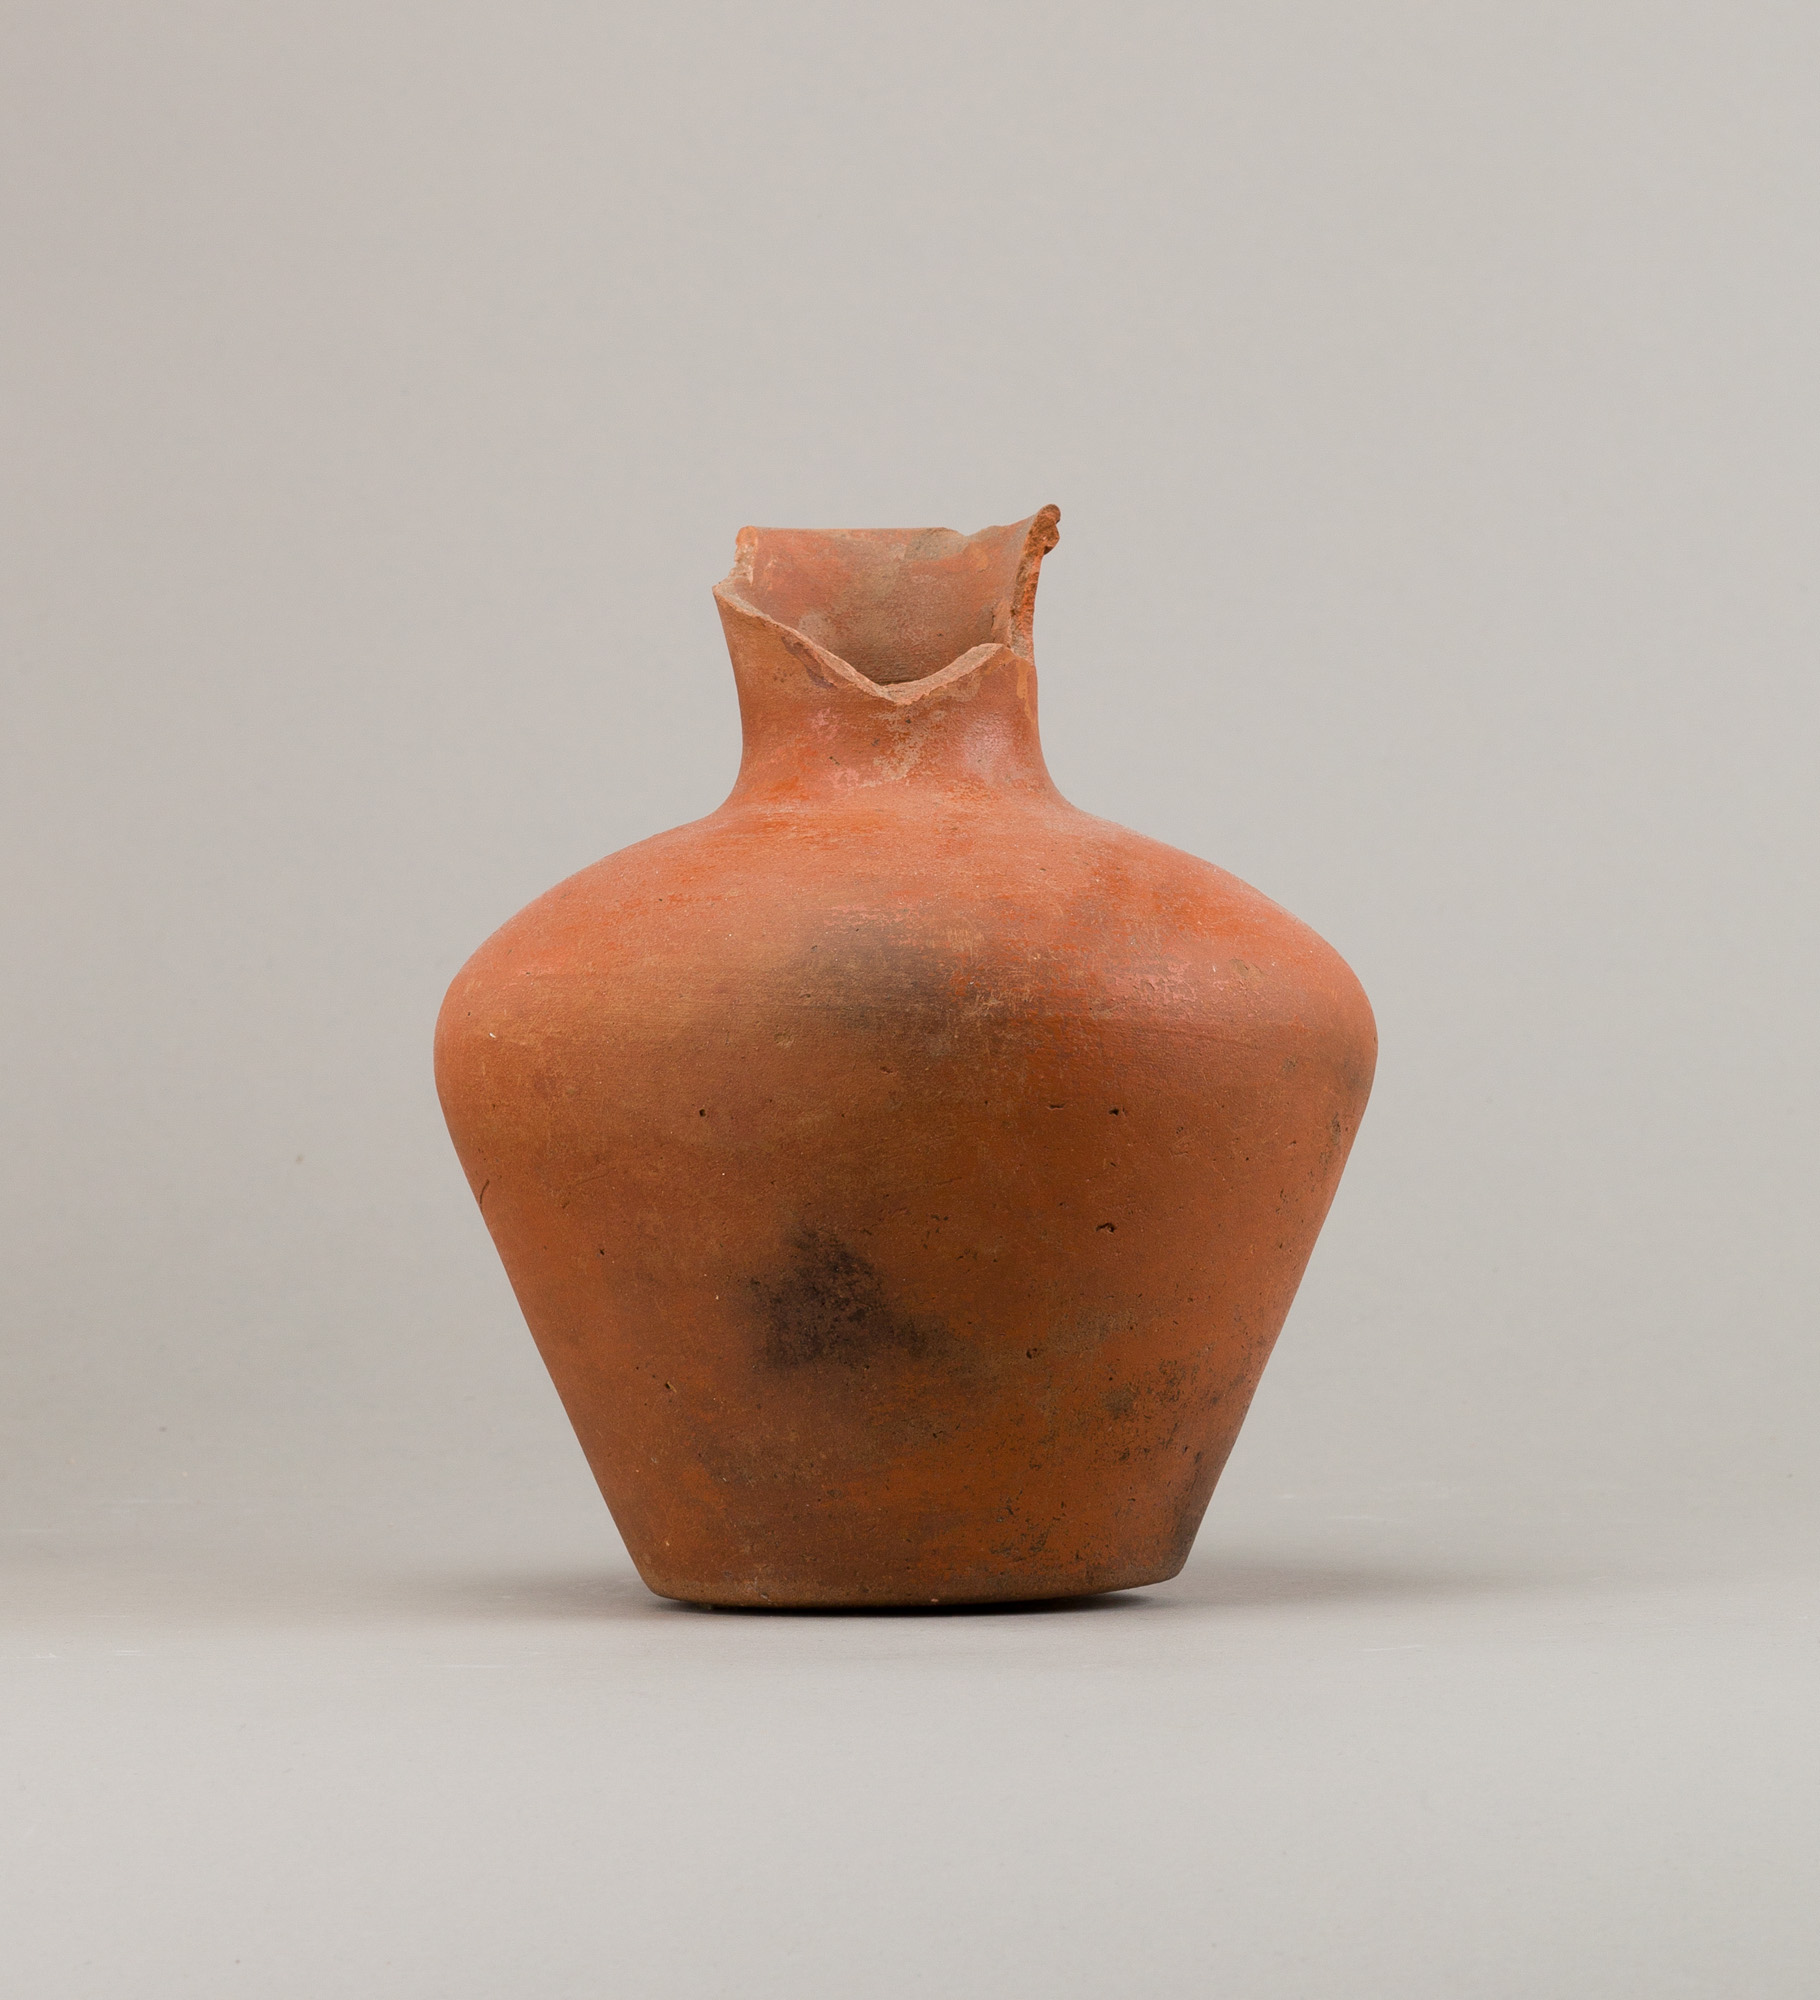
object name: jar, flat base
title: Jar with flat base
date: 2649-2100 BCE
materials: pottery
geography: egypt